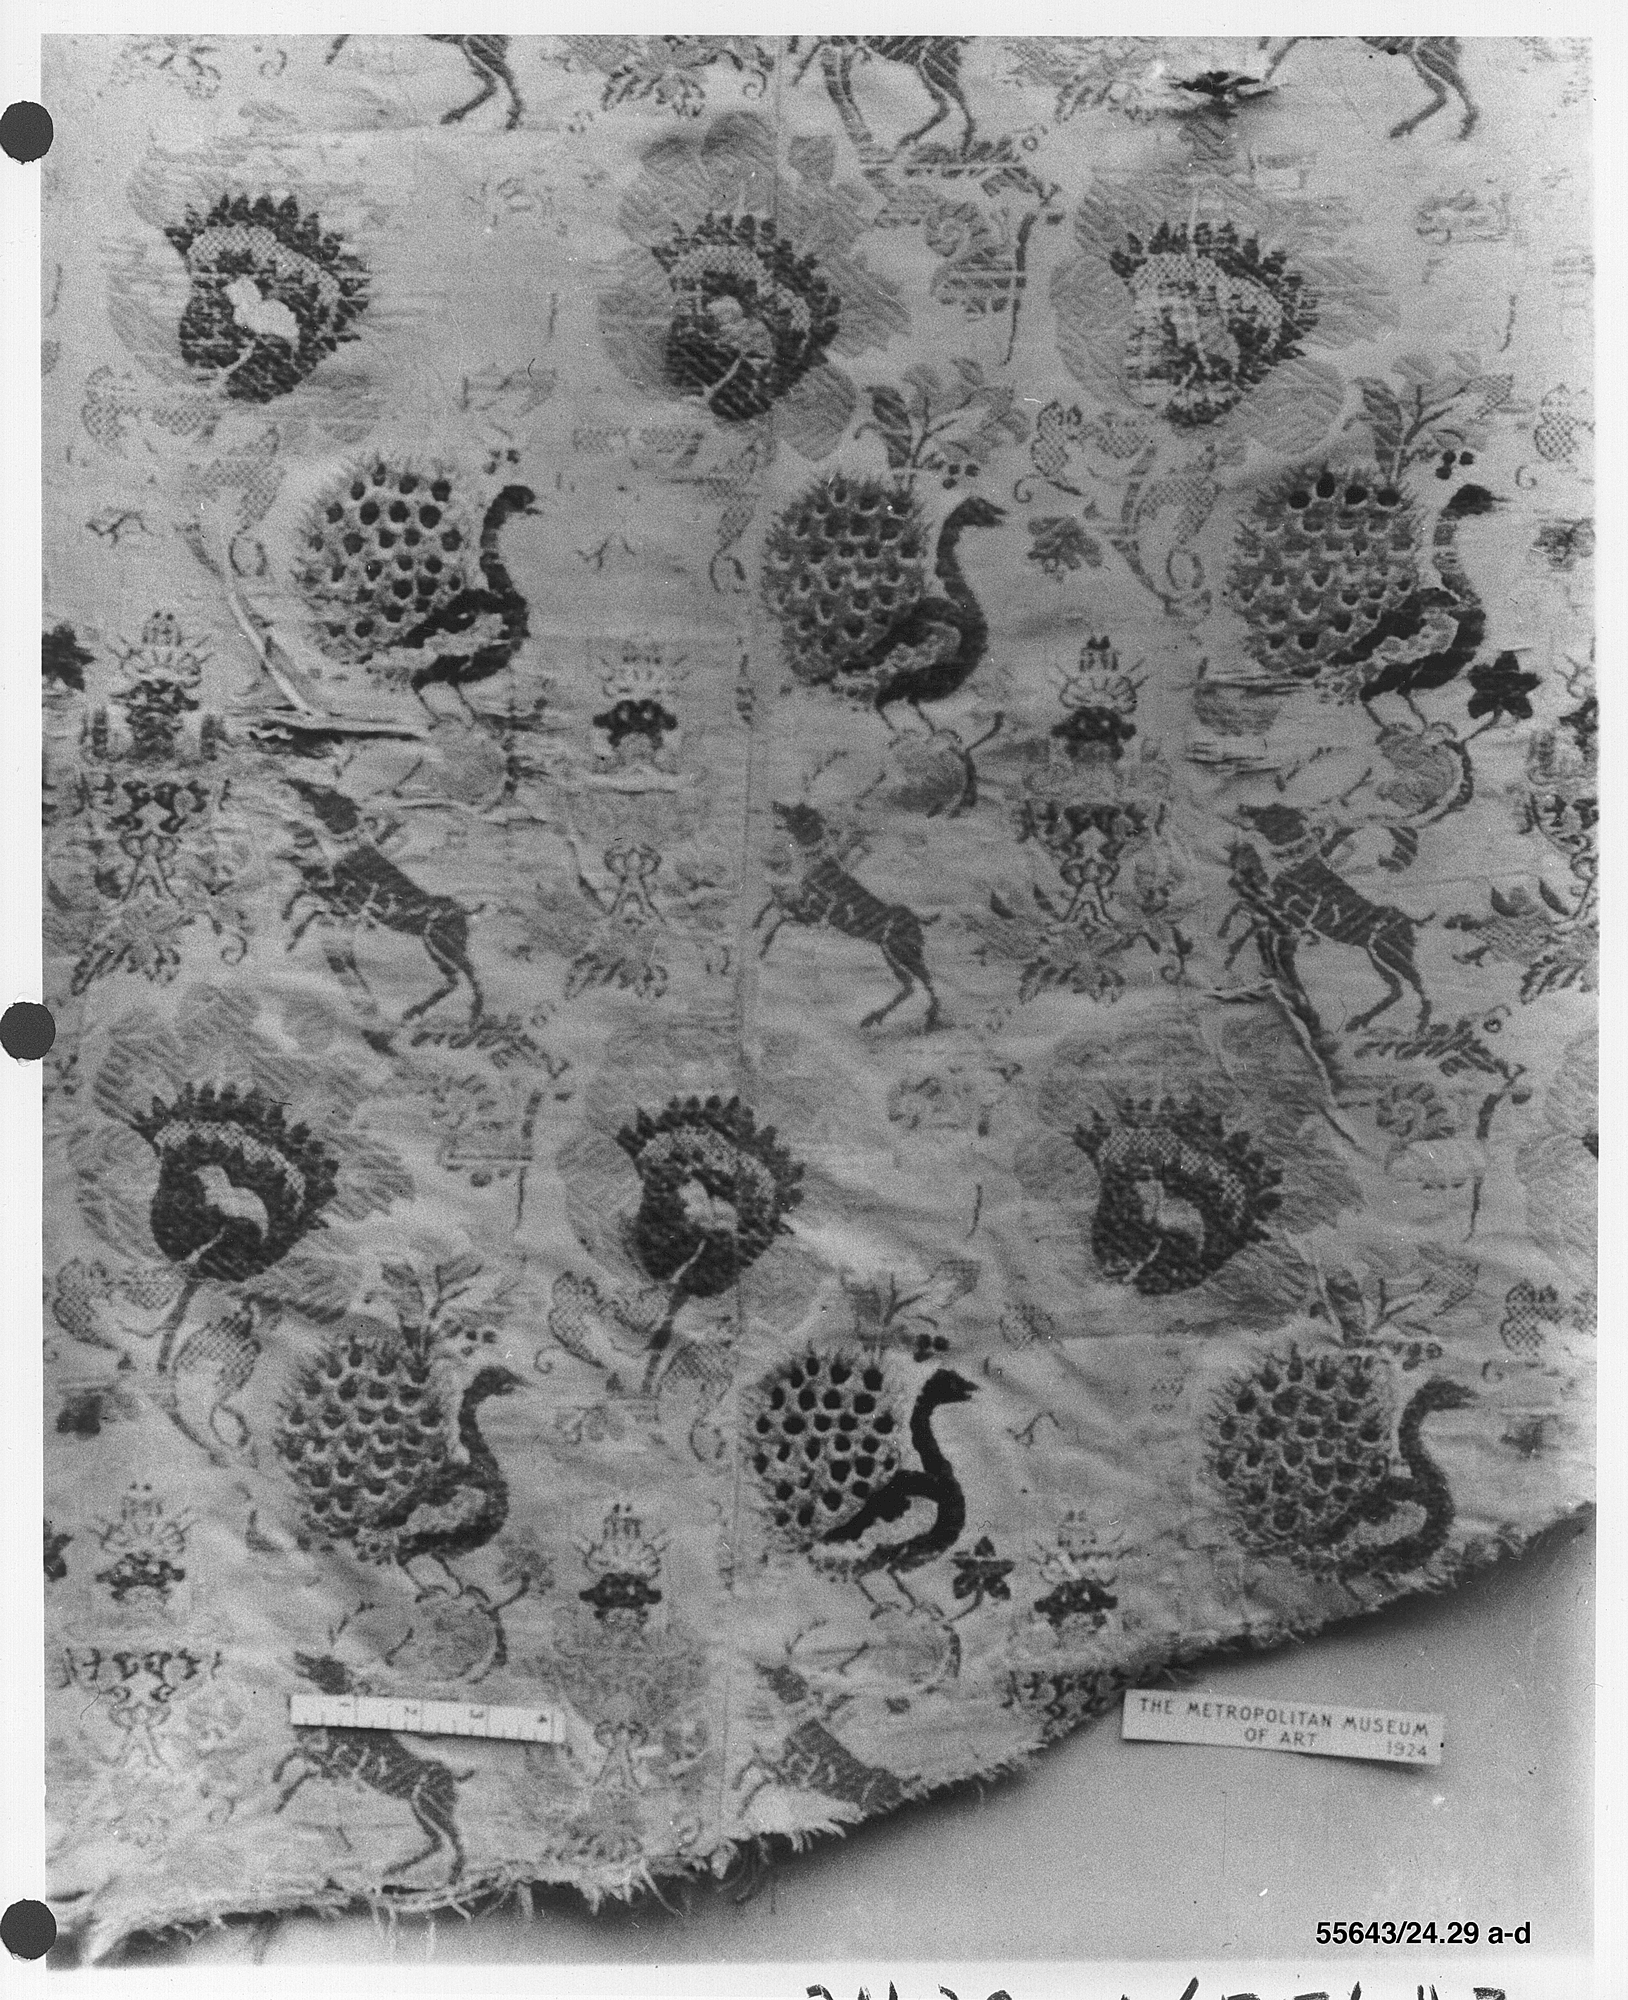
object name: piece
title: Pieces (4)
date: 1601-1700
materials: silk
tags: peacocks,deer,flowers